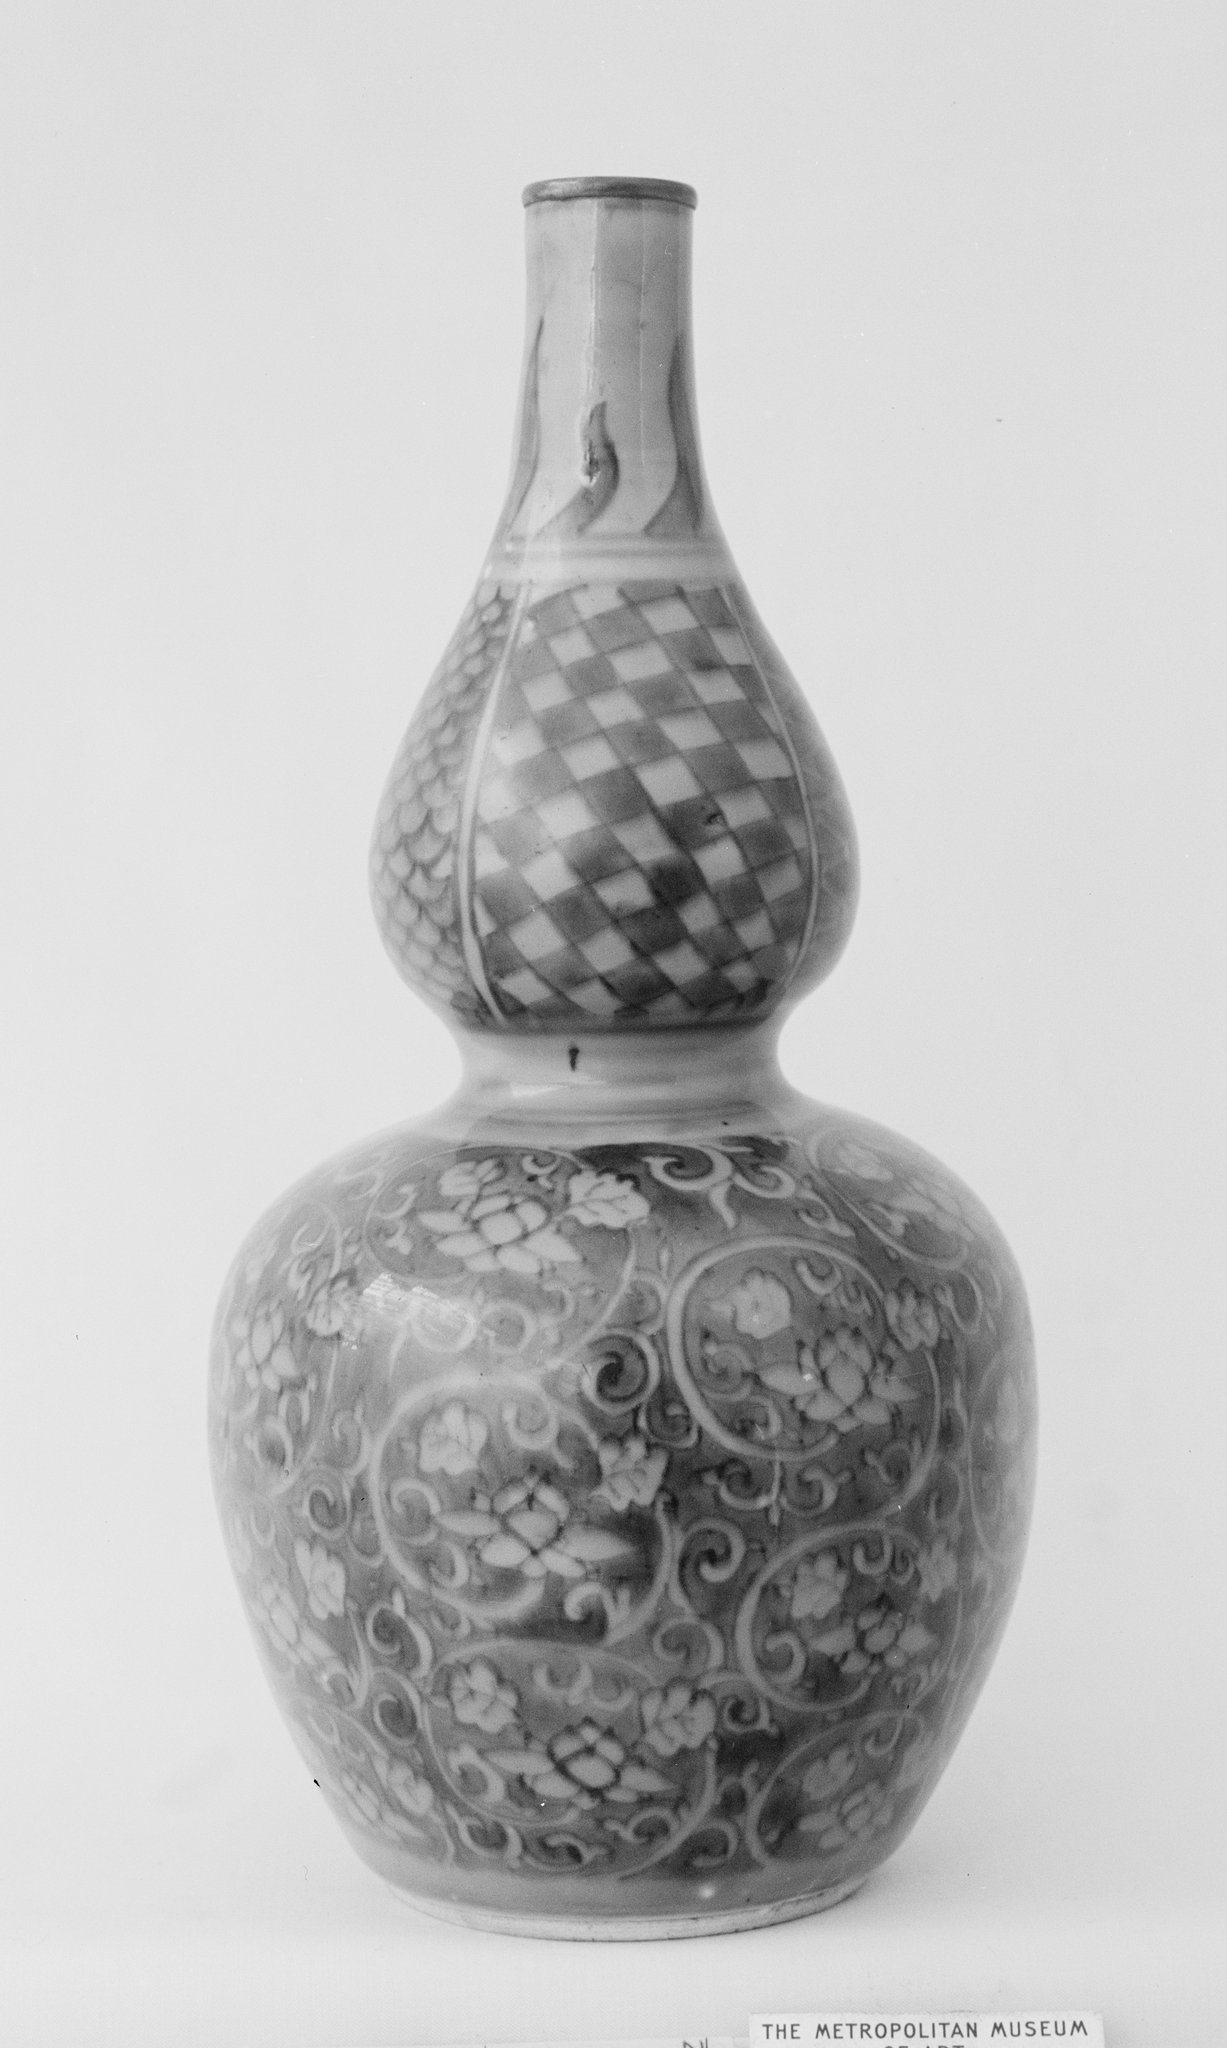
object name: bottle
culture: japanese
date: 1701-1800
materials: glaze, porcelain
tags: flowers,leaves